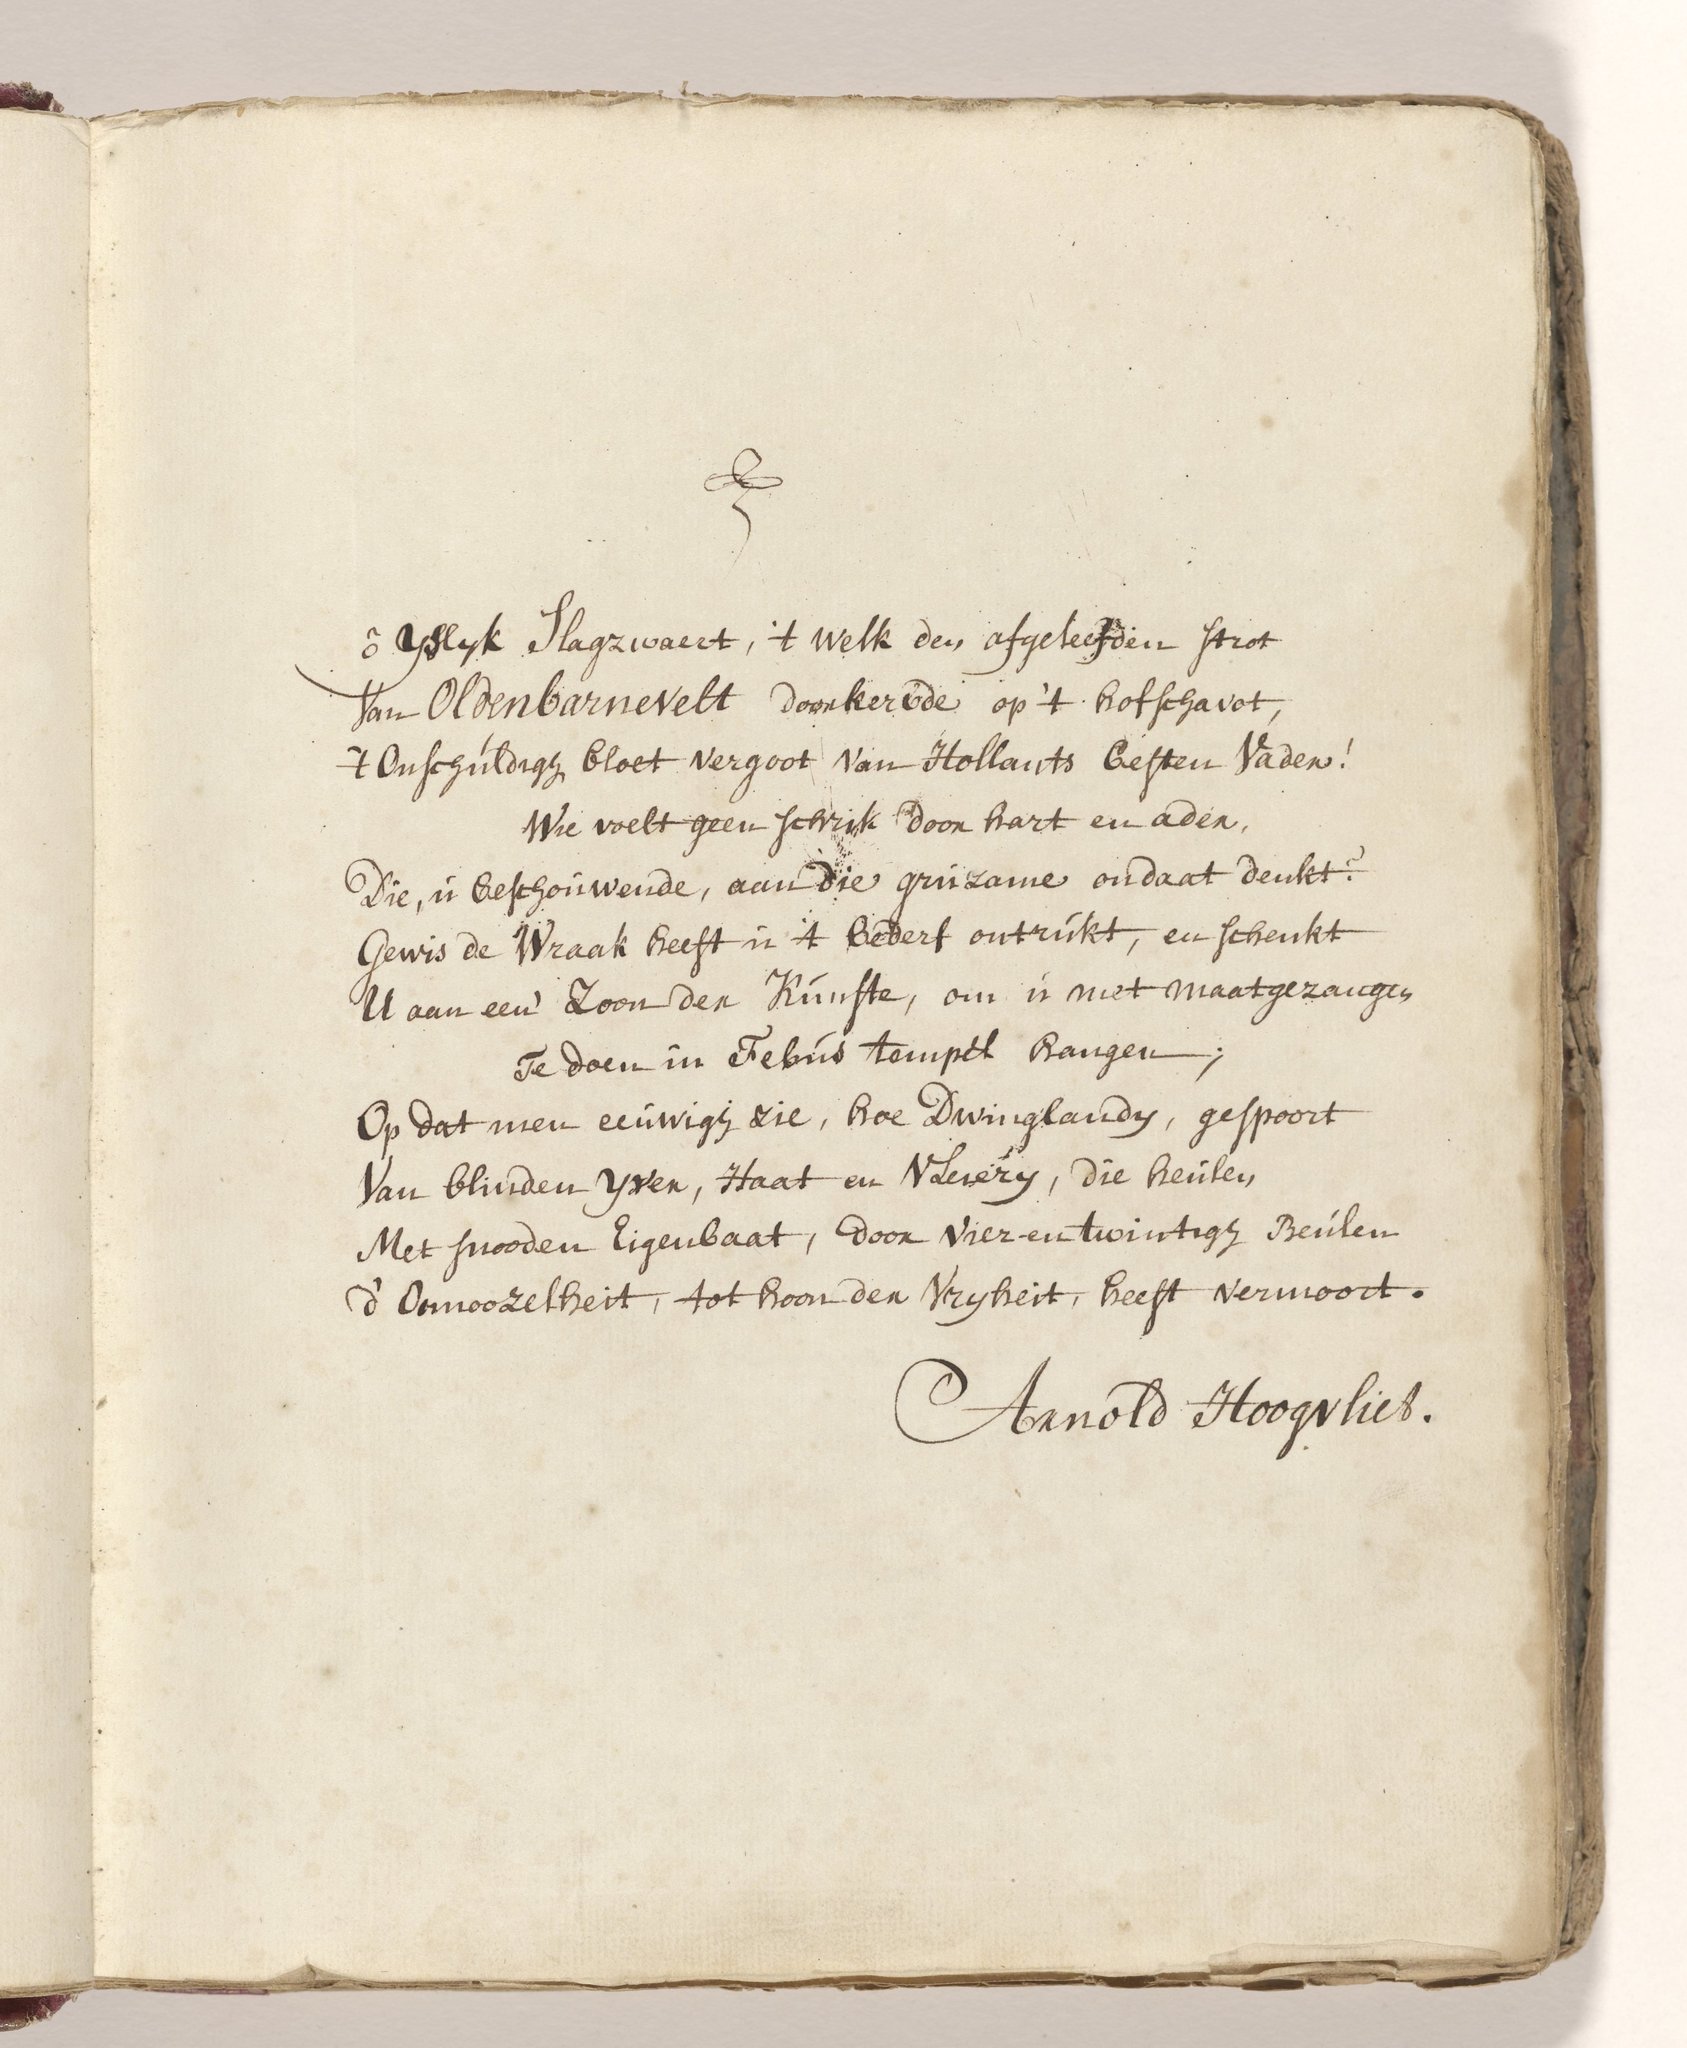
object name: manuscript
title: Gedicht op het zwaard waarmee Johan van Oldenbarnevelt in 1619 zou zijn onthoofd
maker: arnold hoogvliet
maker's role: dichter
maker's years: 1687-1763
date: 1743-1745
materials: ink, paper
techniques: writing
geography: netherlands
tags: the hague, johan van oldenbarnevelt, rotterdam, dordrecht, print maker, frans greenwood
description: Vers van Arnold Hoogvliet. Onderdeel van het boek met gedichten uit de jaren 1743-1745 op het zwaard waarmee Johan van Oldenbarnevelt in 1619 zou zijn onthoofd. Het zwaard was eigendom van Frans Greenwood.